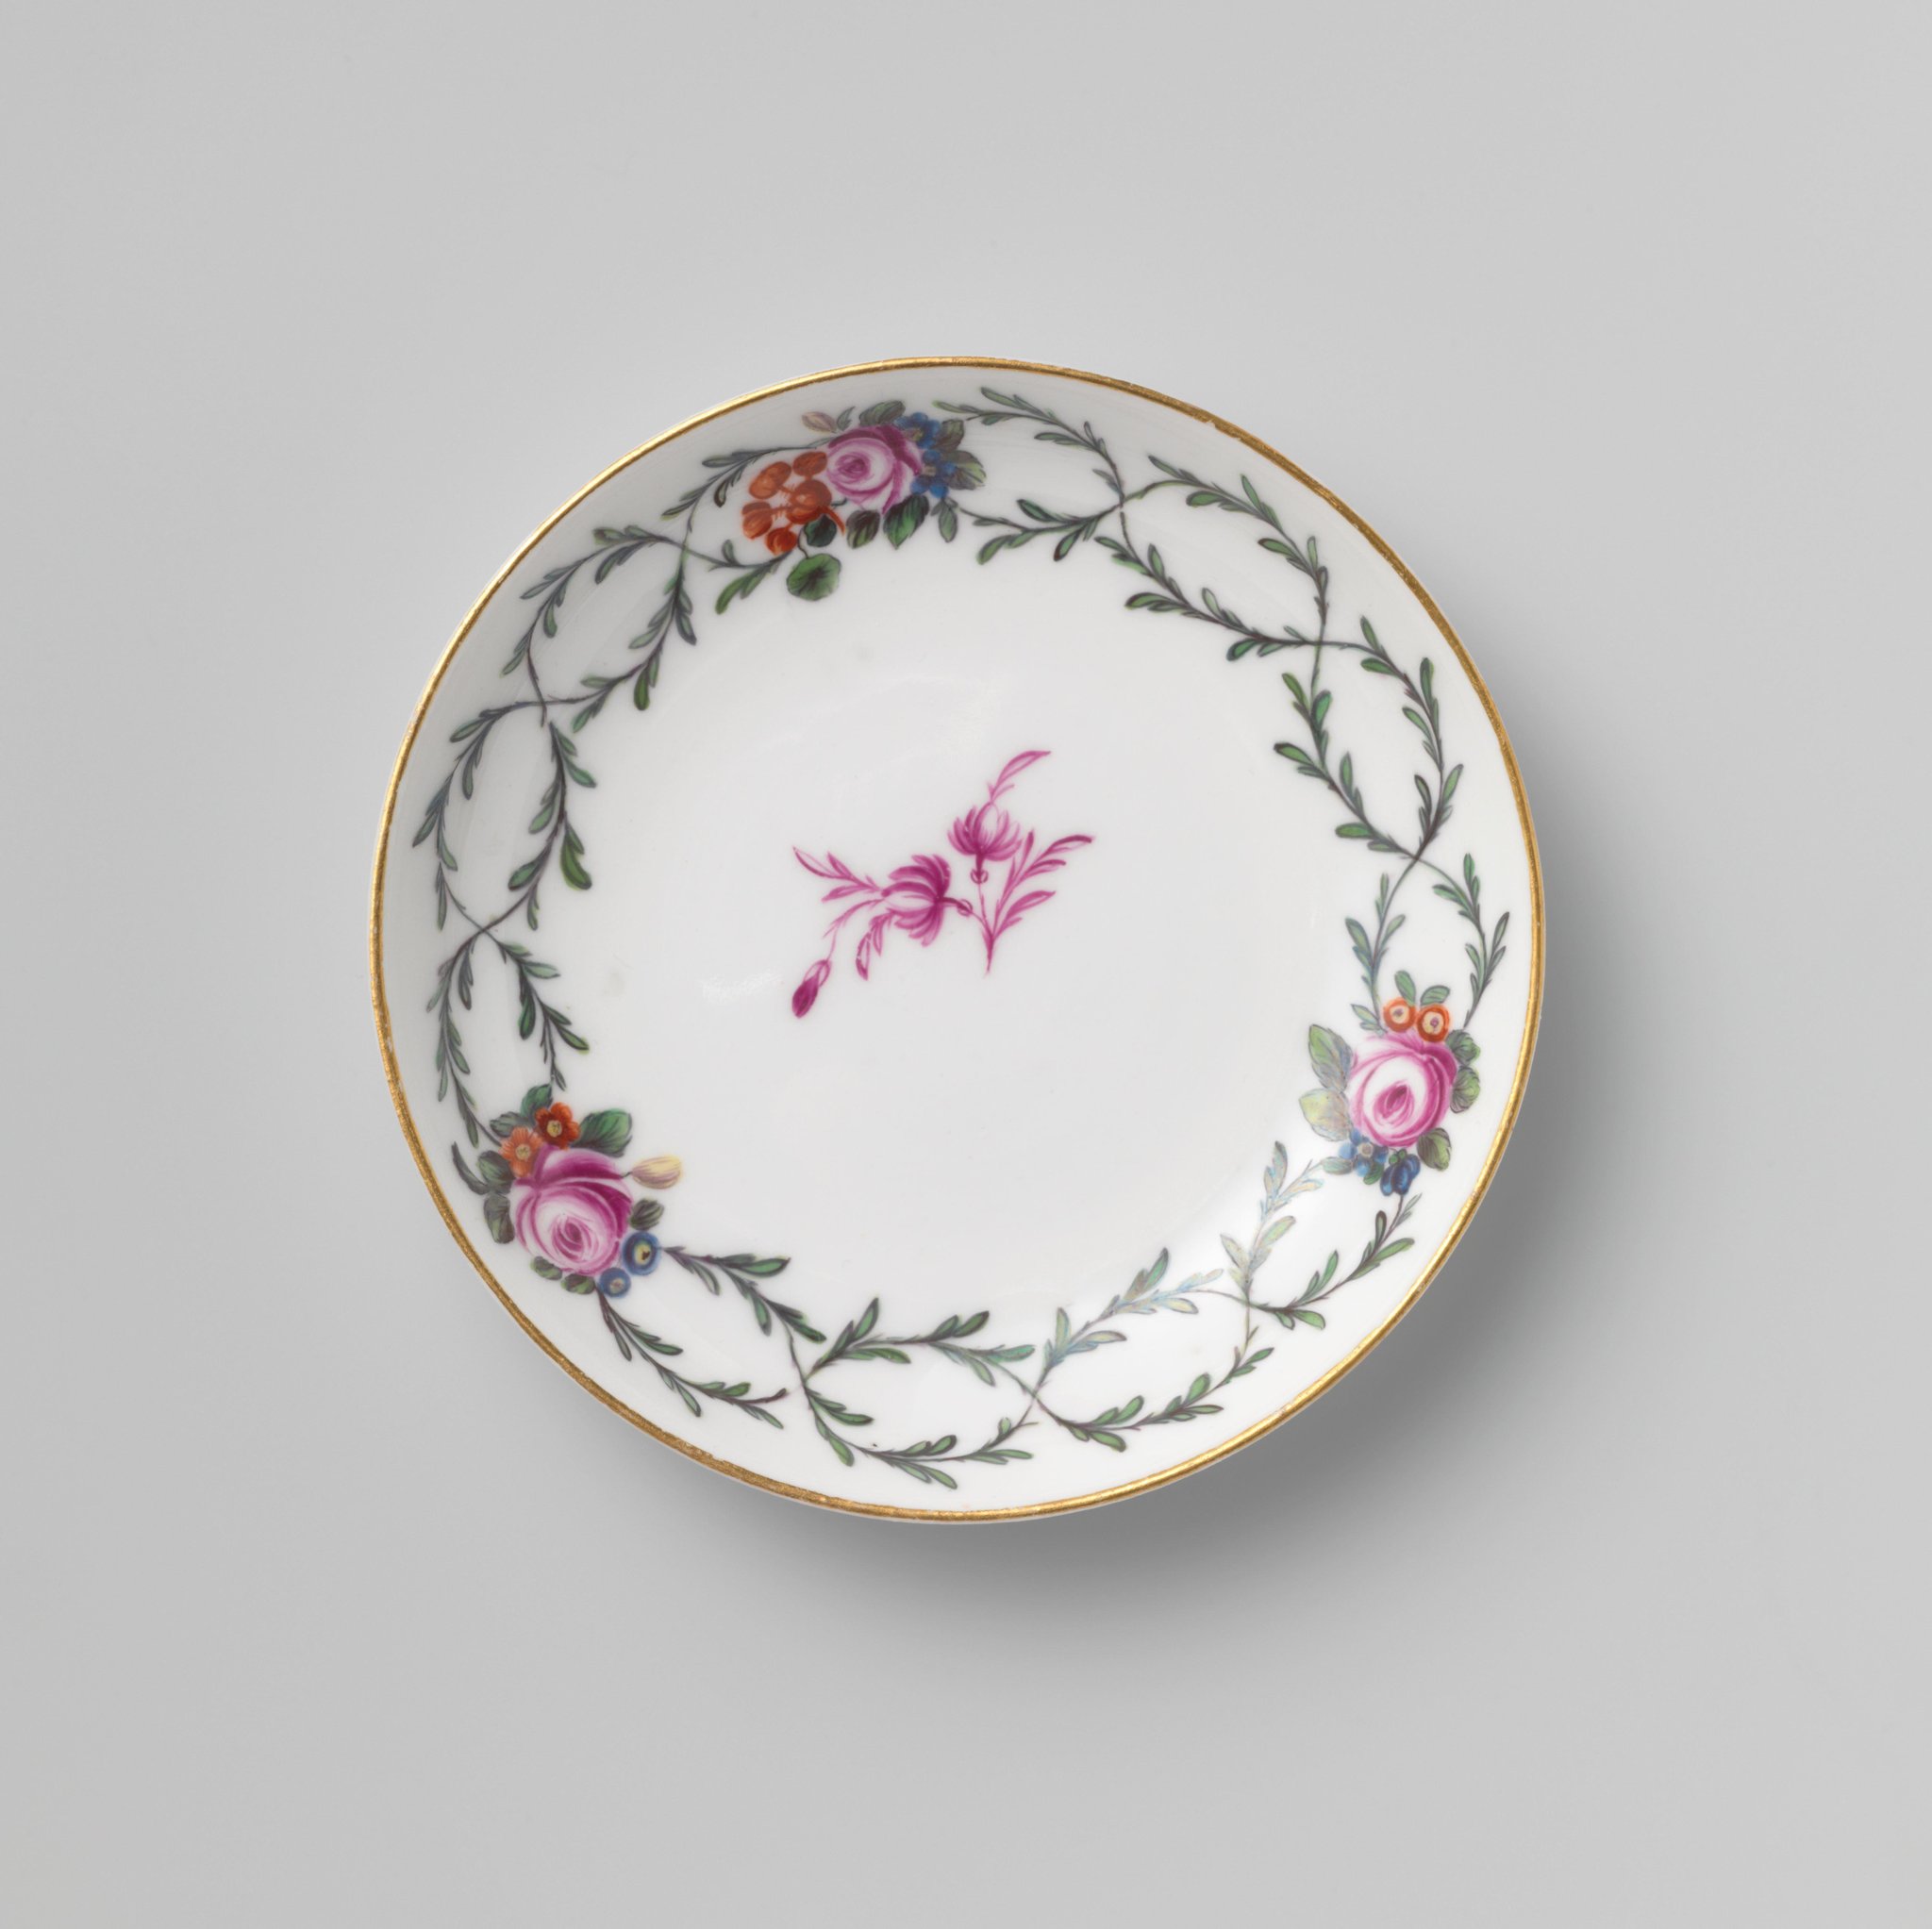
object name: platter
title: Schotel, beschilderd met een band van elkaar kruisende bladslingers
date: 1778-1782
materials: porcelain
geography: loosdrecht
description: Tea cup and saucer. Porcelain. Loosdrecht, c. 1778 - 1782. Factory of Joannes de Mol.